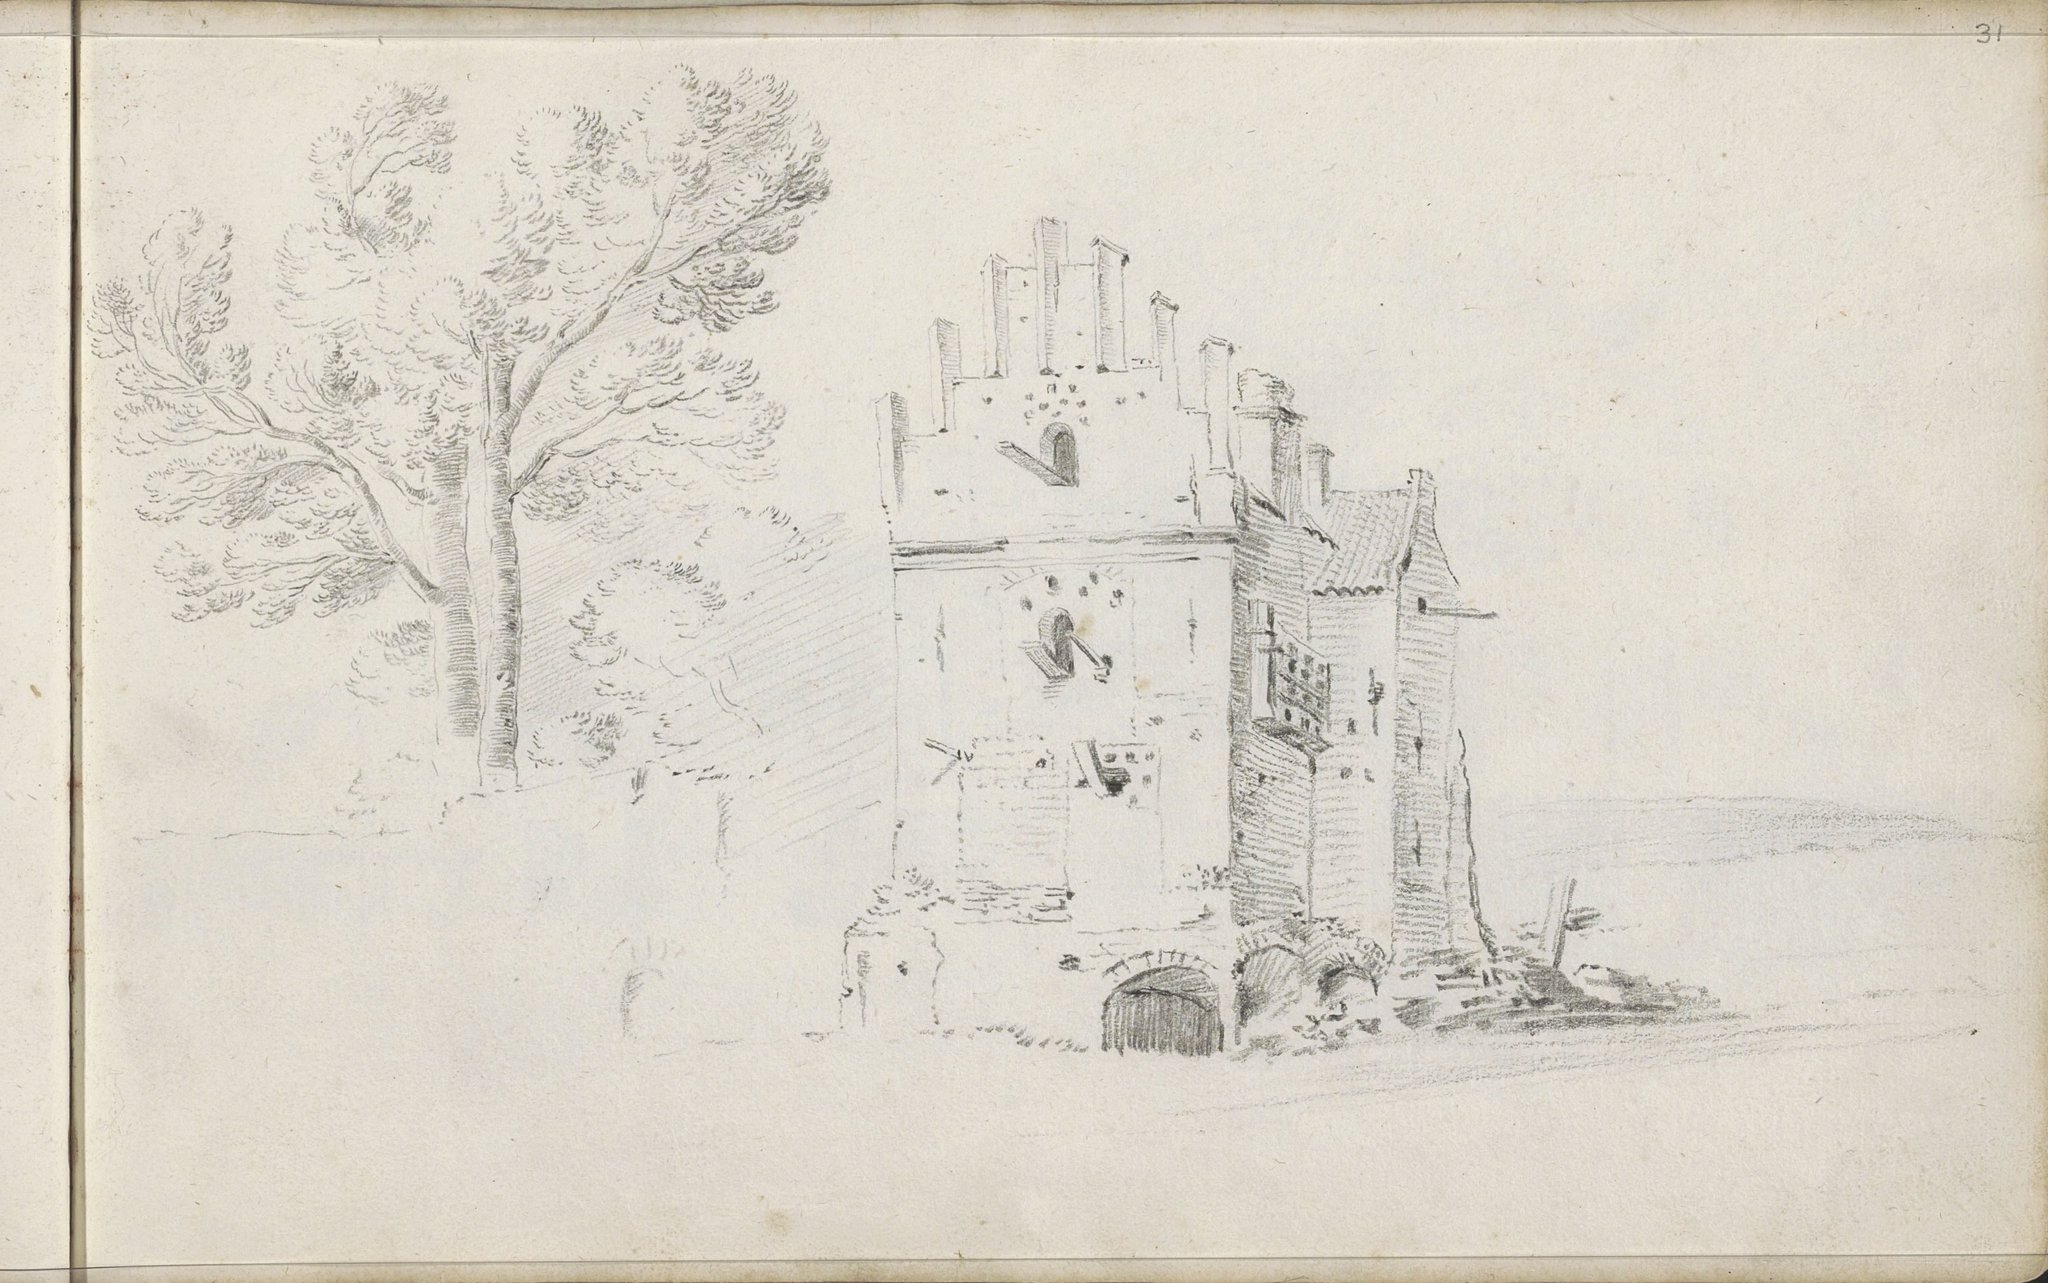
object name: sketchbook leaf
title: Landschap met ruïne in gebruik als duiventil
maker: pieter moninckx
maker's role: draughtsman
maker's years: 1606-1686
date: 1645-1646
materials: chalk, paper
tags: dove-cote, landscape with ruins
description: Blad 31 recto uit een schetsboek met 39 bladen.